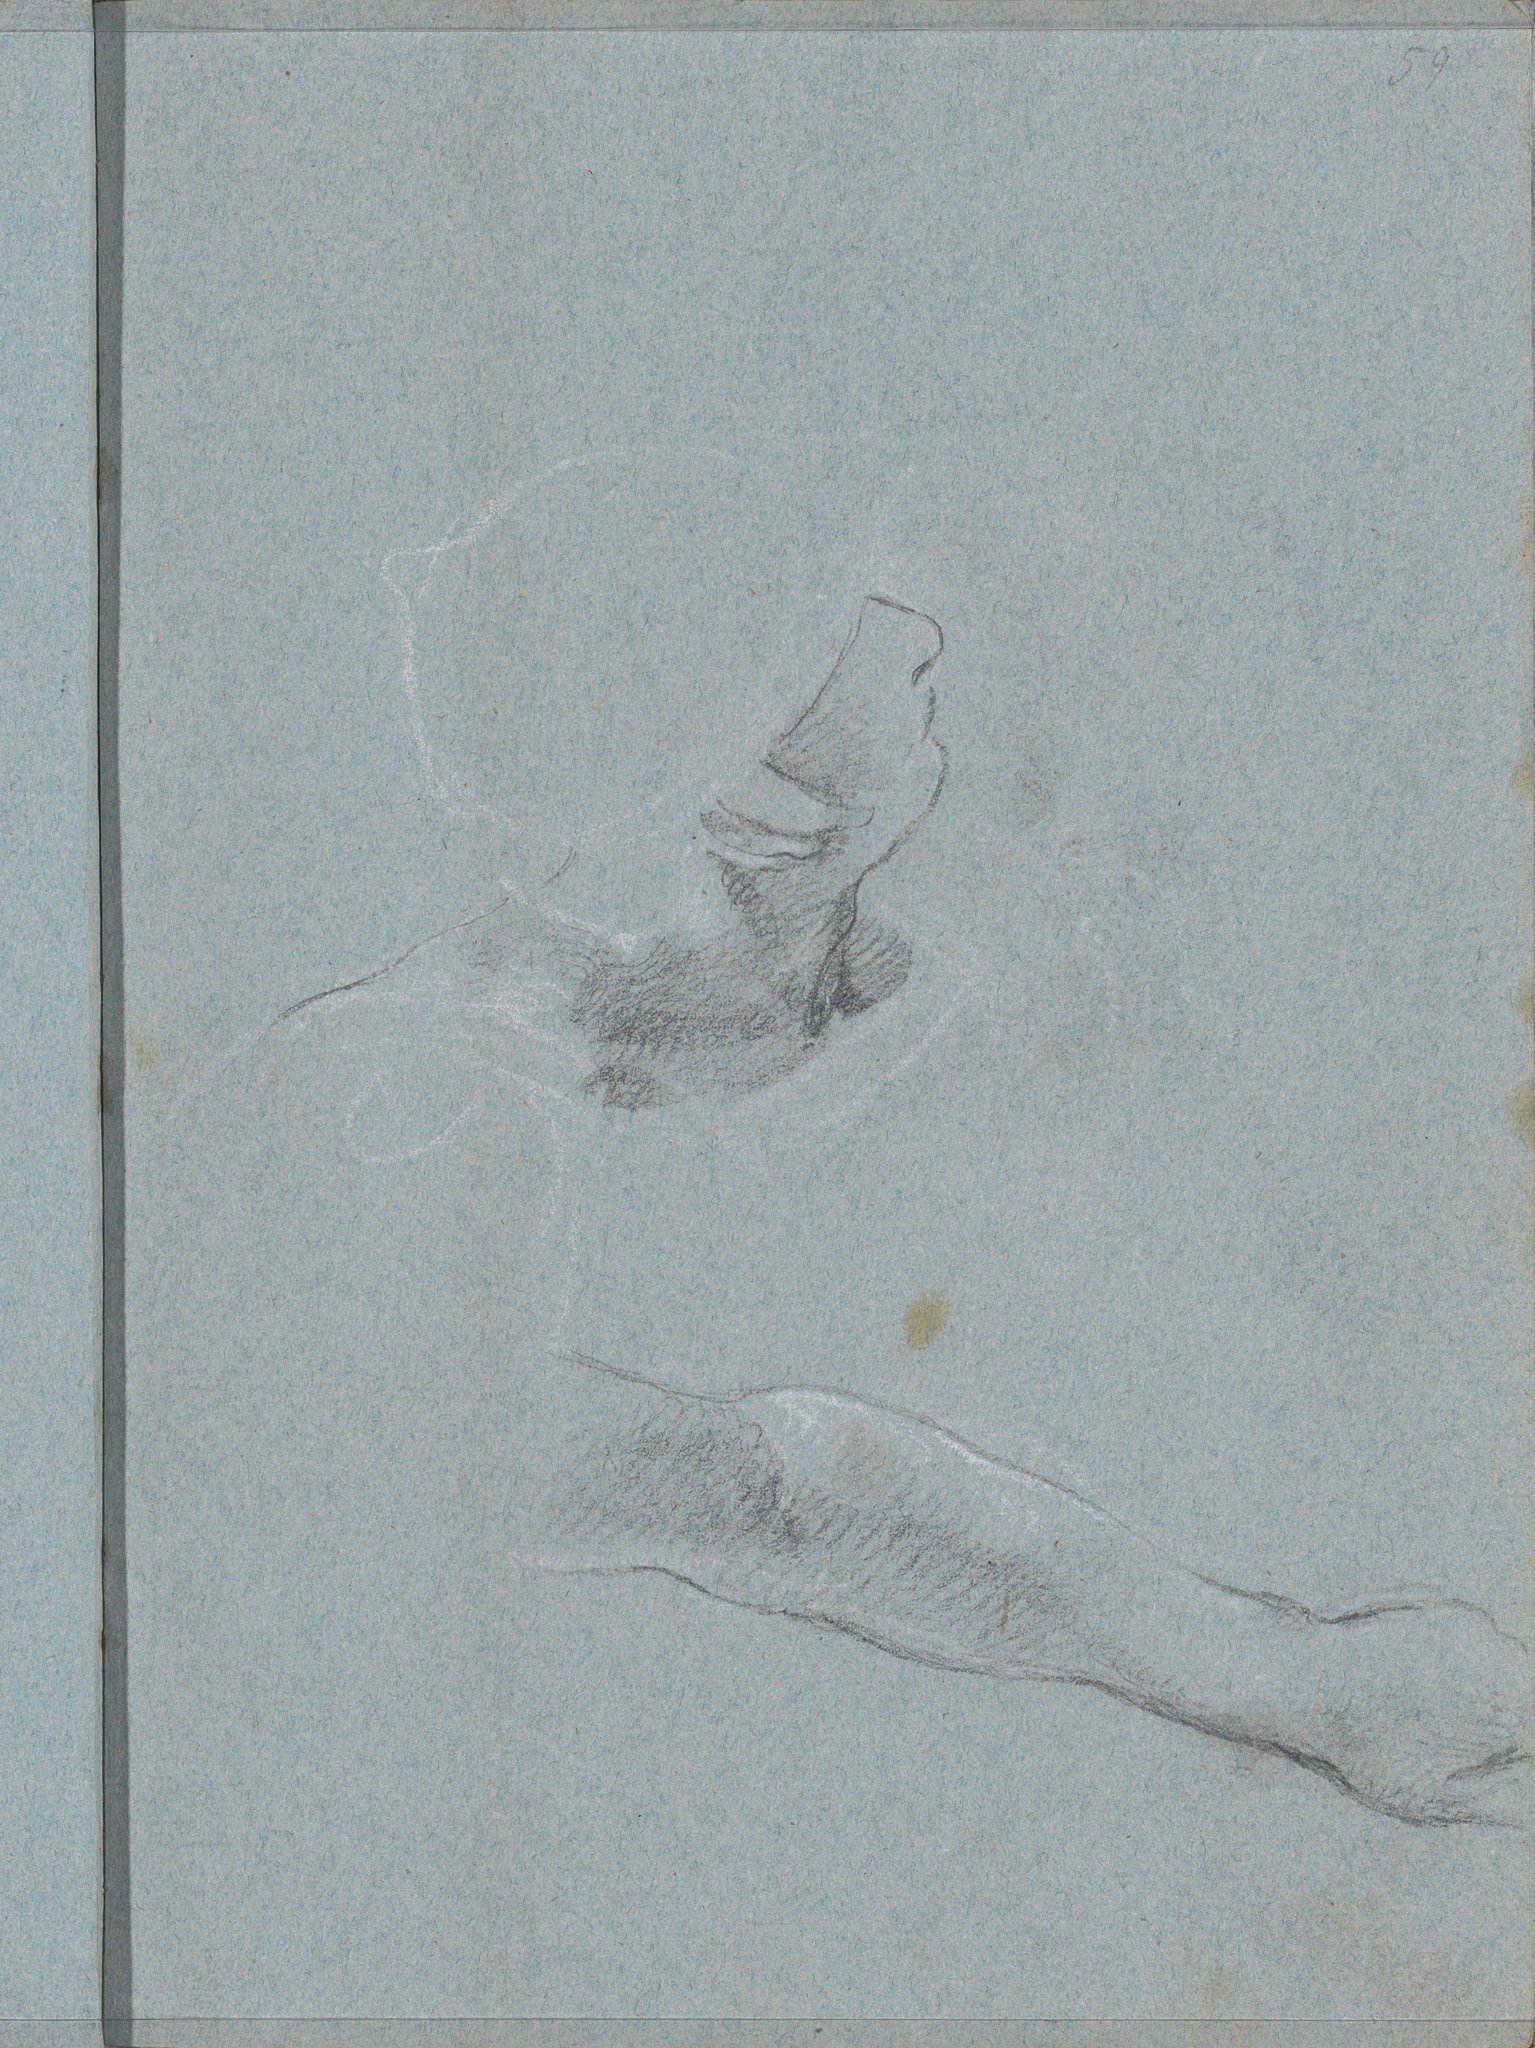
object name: sketchbook leaf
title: Kop en een arm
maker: lorenzo baldissera tiepolo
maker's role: draughtsman, print maker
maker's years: 1736-1776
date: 1751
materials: chalk, paper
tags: head (human), arms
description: Bladzijde 59 uit een schetsboek met 158 bladzijden.